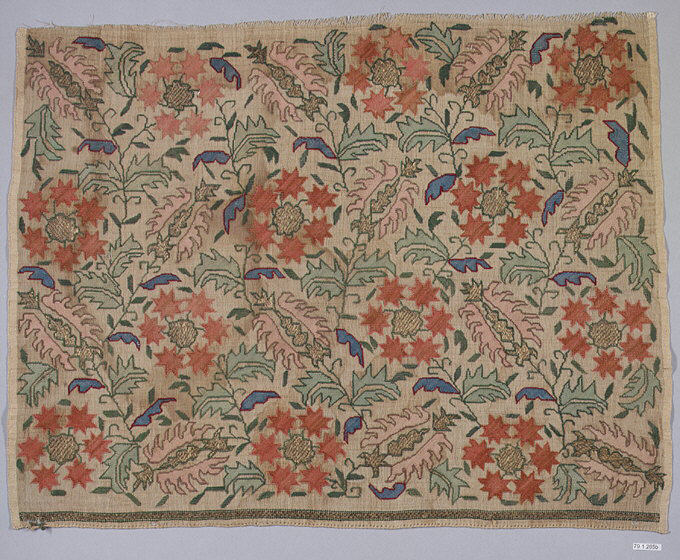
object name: towel end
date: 1801-1900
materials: linen, metal thread, silk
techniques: embroidery, weave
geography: turkey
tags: flowers